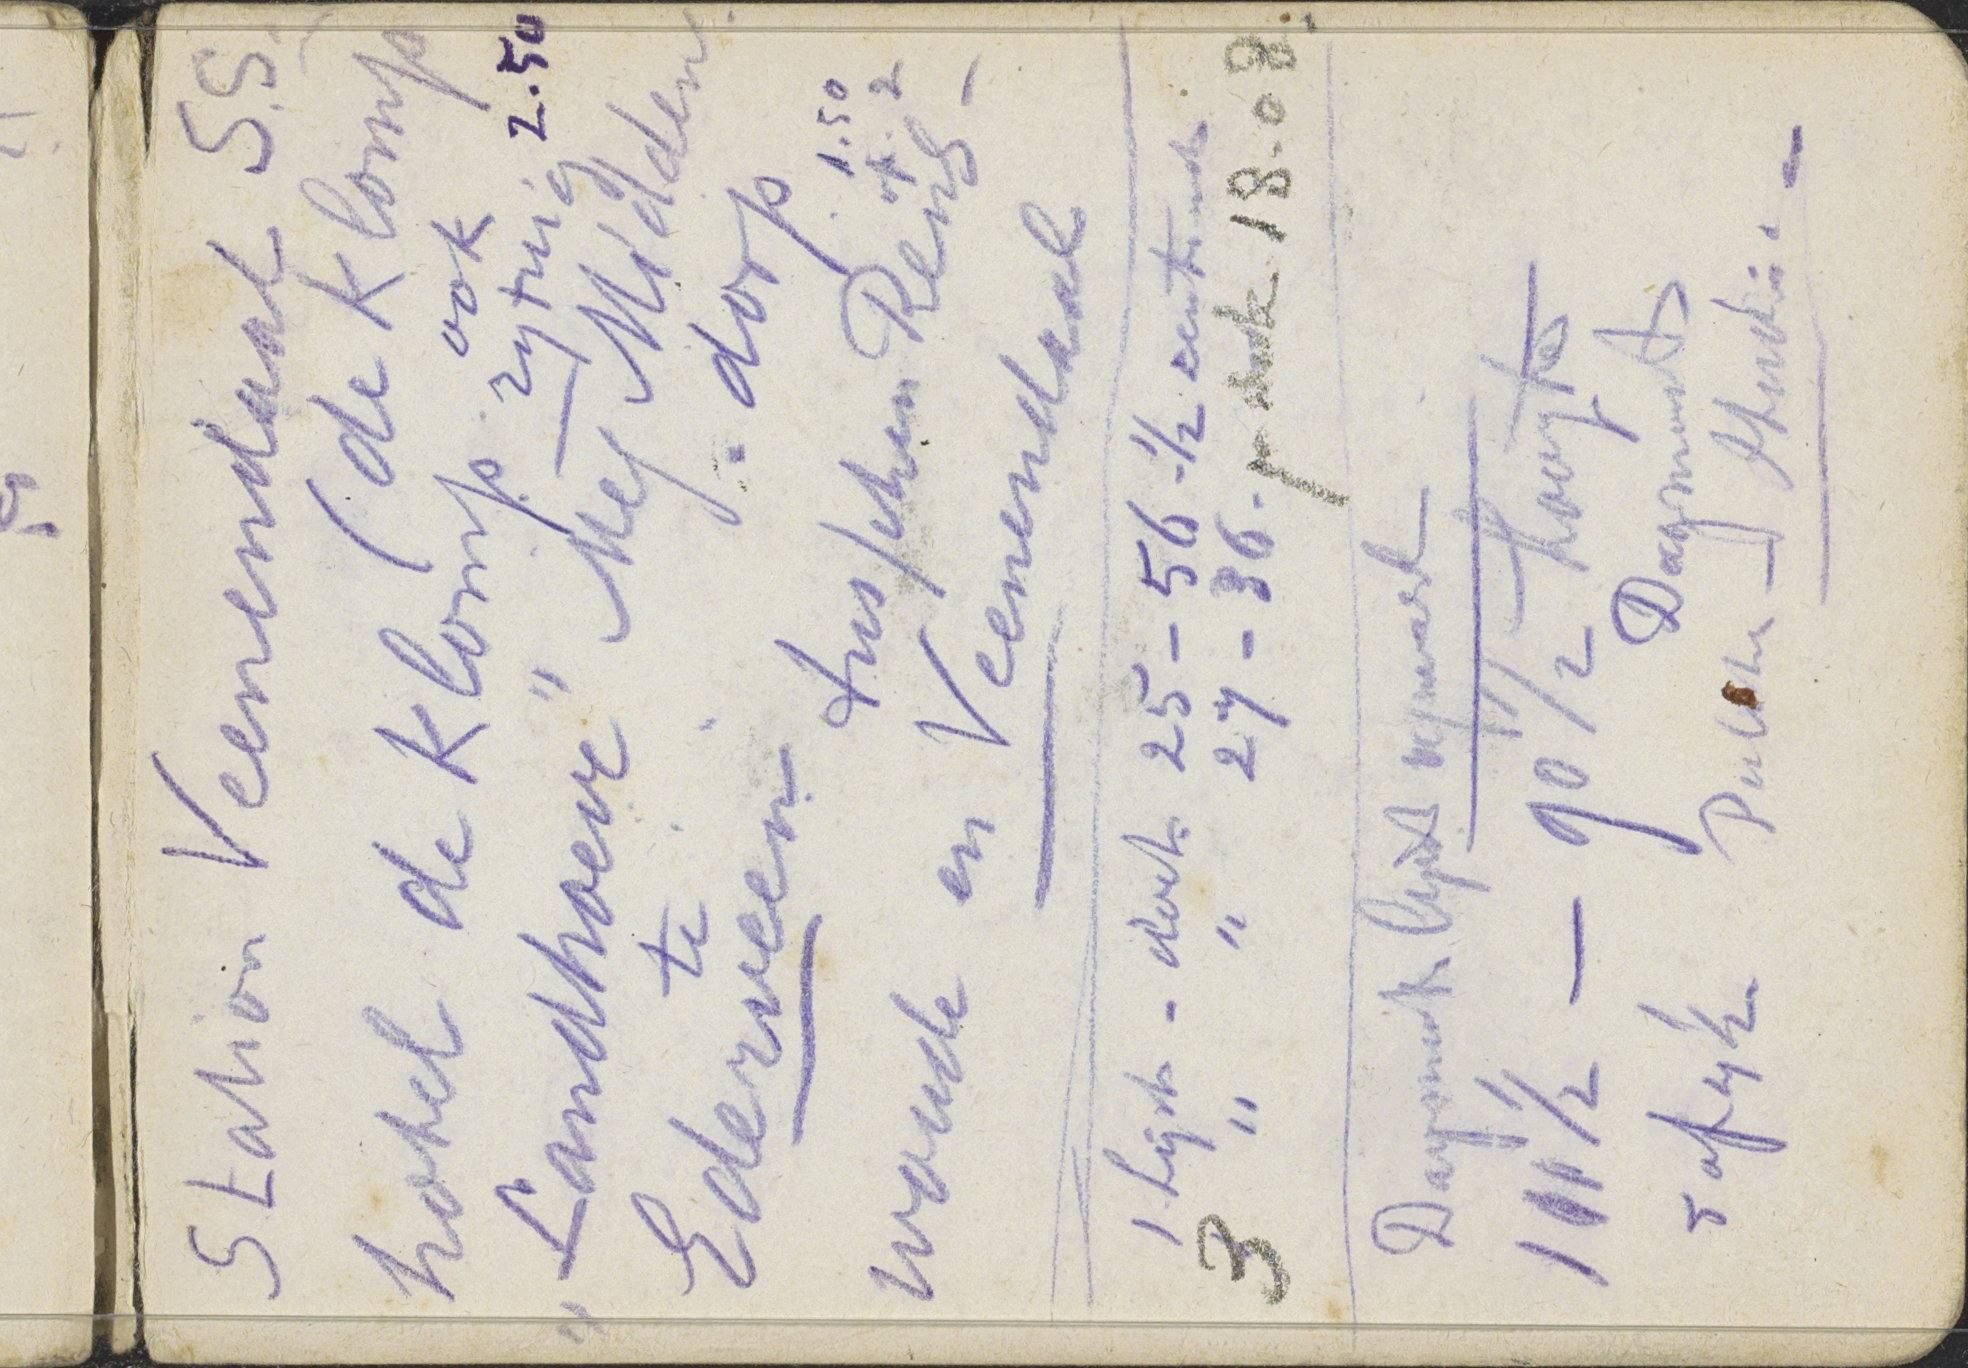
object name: endleaf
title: Notities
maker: willem cornelis rip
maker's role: draughtsman, painter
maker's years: 1856-1922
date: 1905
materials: paper, pencil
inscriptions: annotation: ‘station Veenendaal S.S./ (de Klomp/ hotel de Klomp ook/ rijtuig 2.50/ "Landhoeve" Mej Midden/ dorp/ te Ederveen/ [...]’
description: Achterste schutblad uit een schetsboek met 42 bladen.